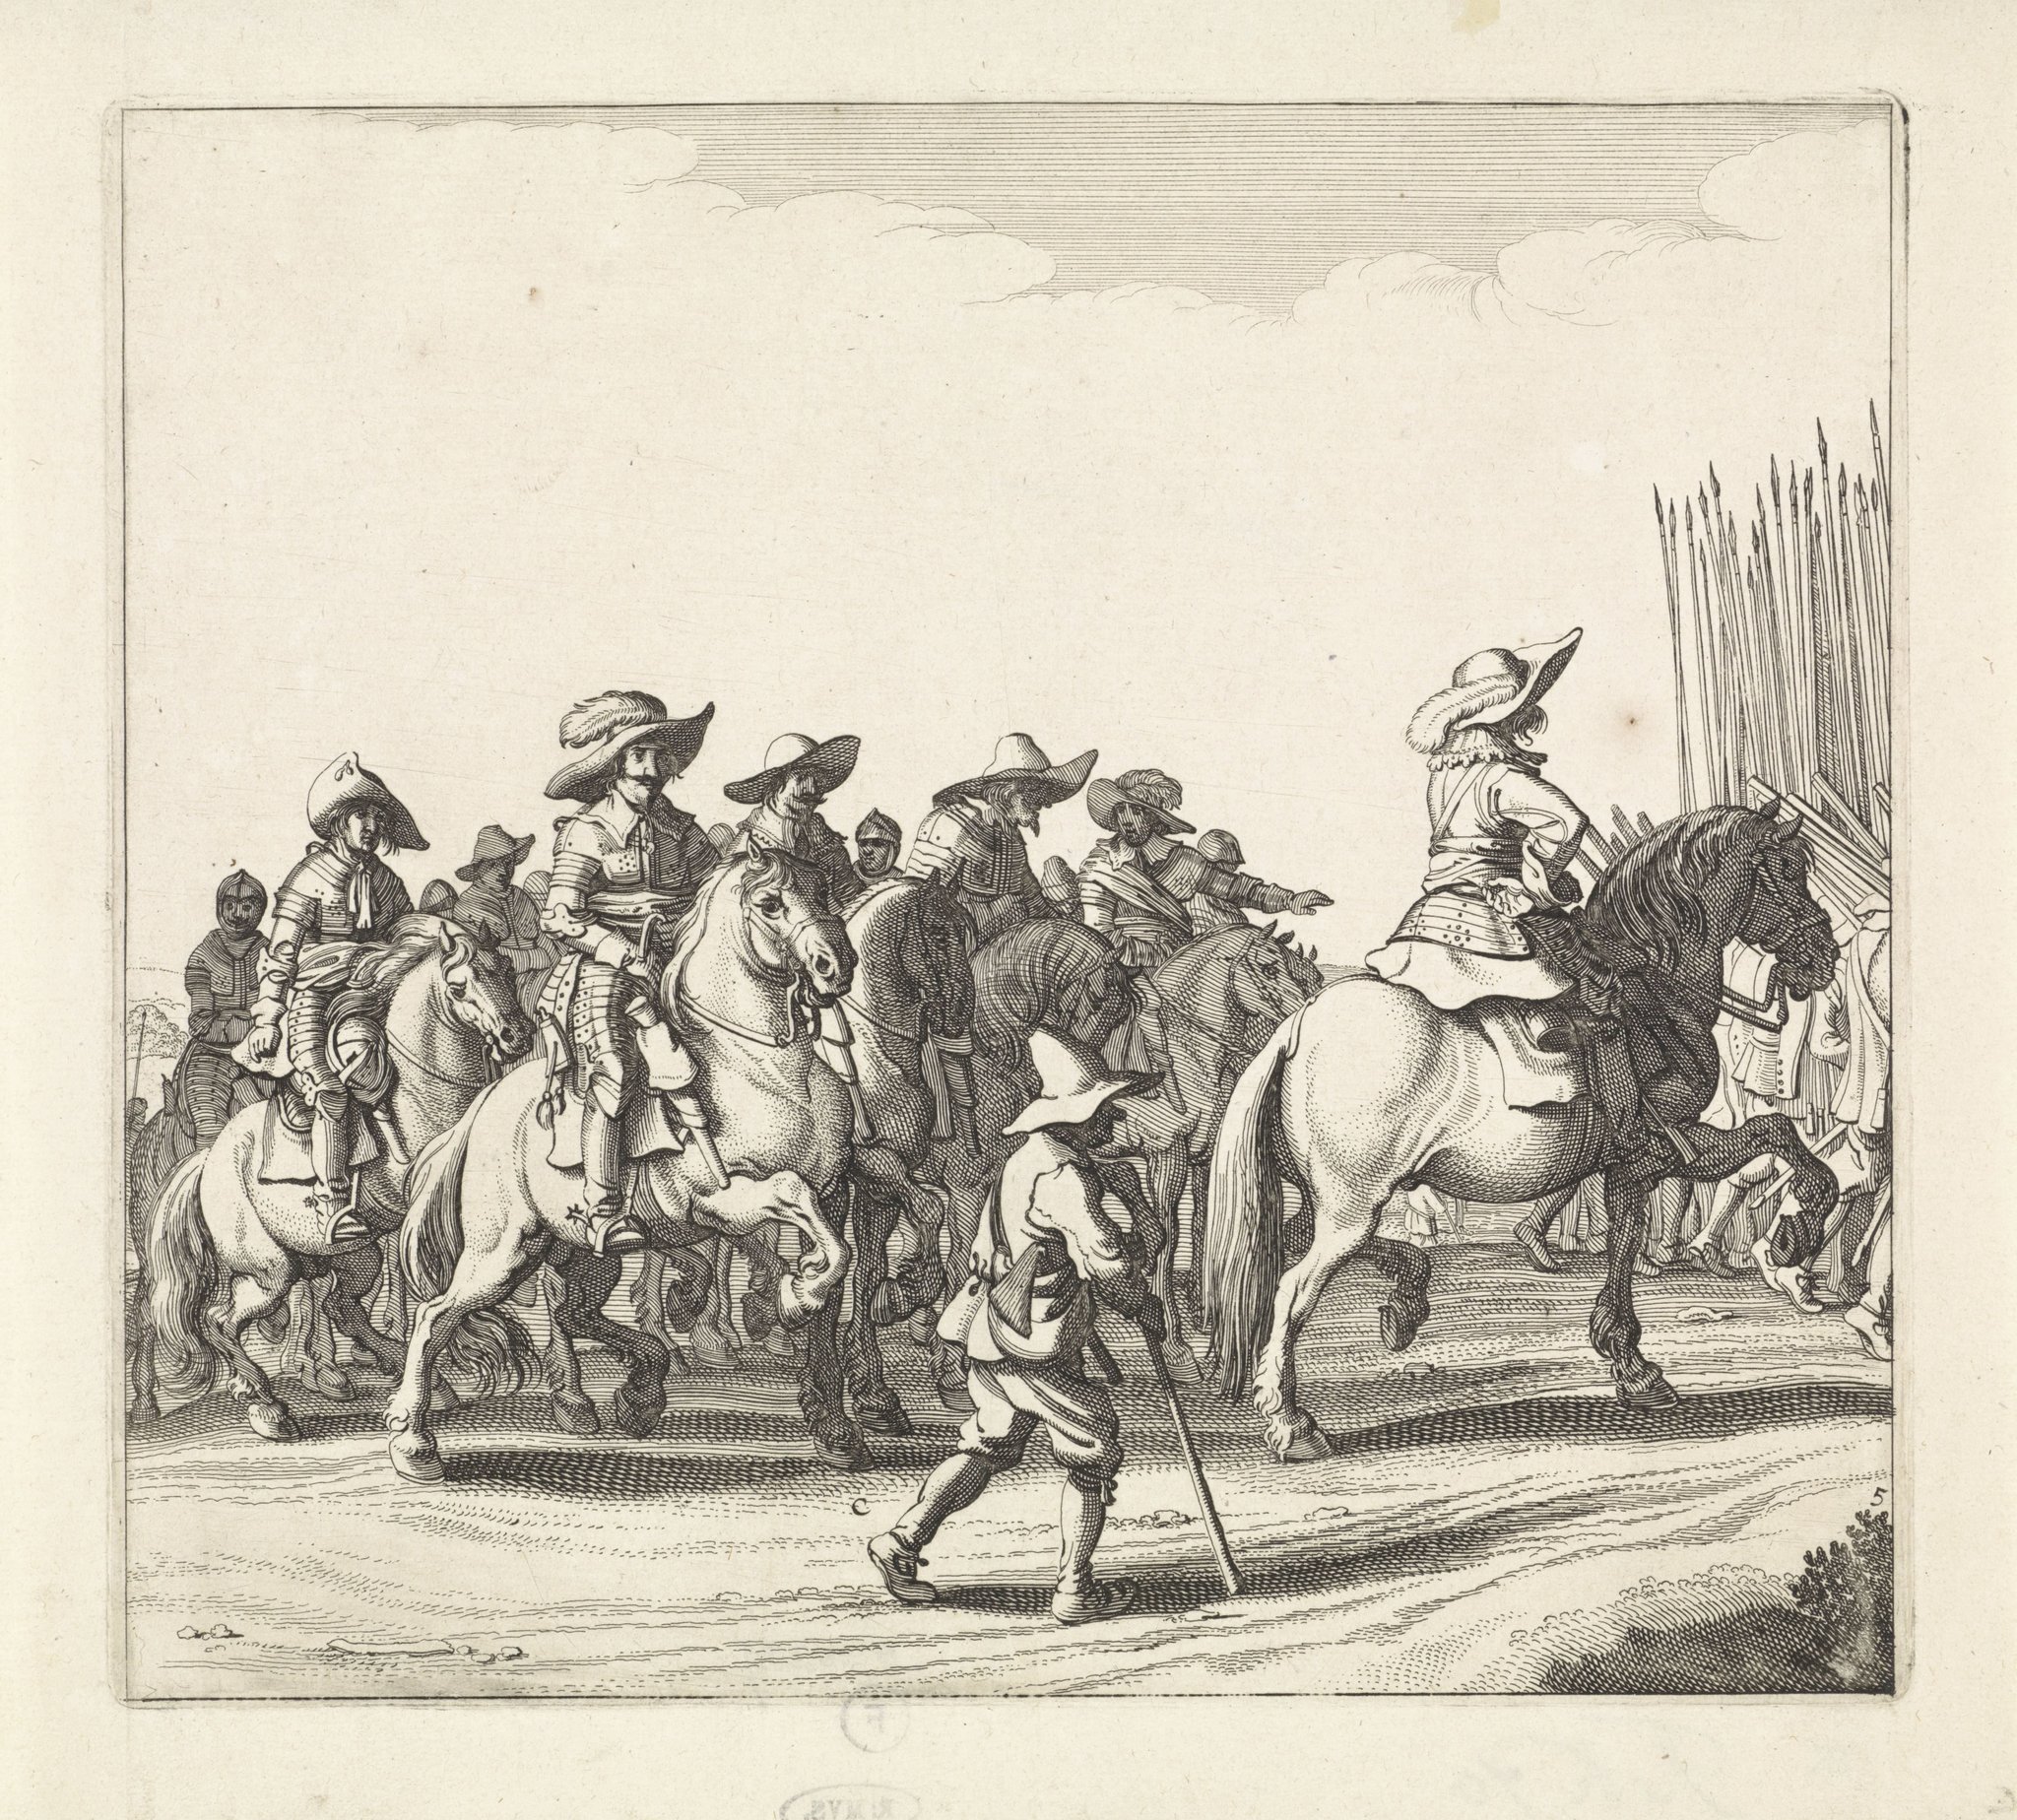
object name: print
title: Discessus Hispanici Praesidii Trajecti ad Mosam Ao. 1632. Die 23 Augusti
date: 1632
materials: paper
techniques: etching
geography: amsterdam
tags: retreat of the defeated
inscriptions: number: ‘5’, collector's mark: Lugt 964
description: Uittocht van het Spaanse leger uit Maastricht, 23 augustus 1632. Vijfde prent uit een fries van zes genummerd prenten. Cavallerie van het Spaanse garnizoen dat Maastricht verlaat.